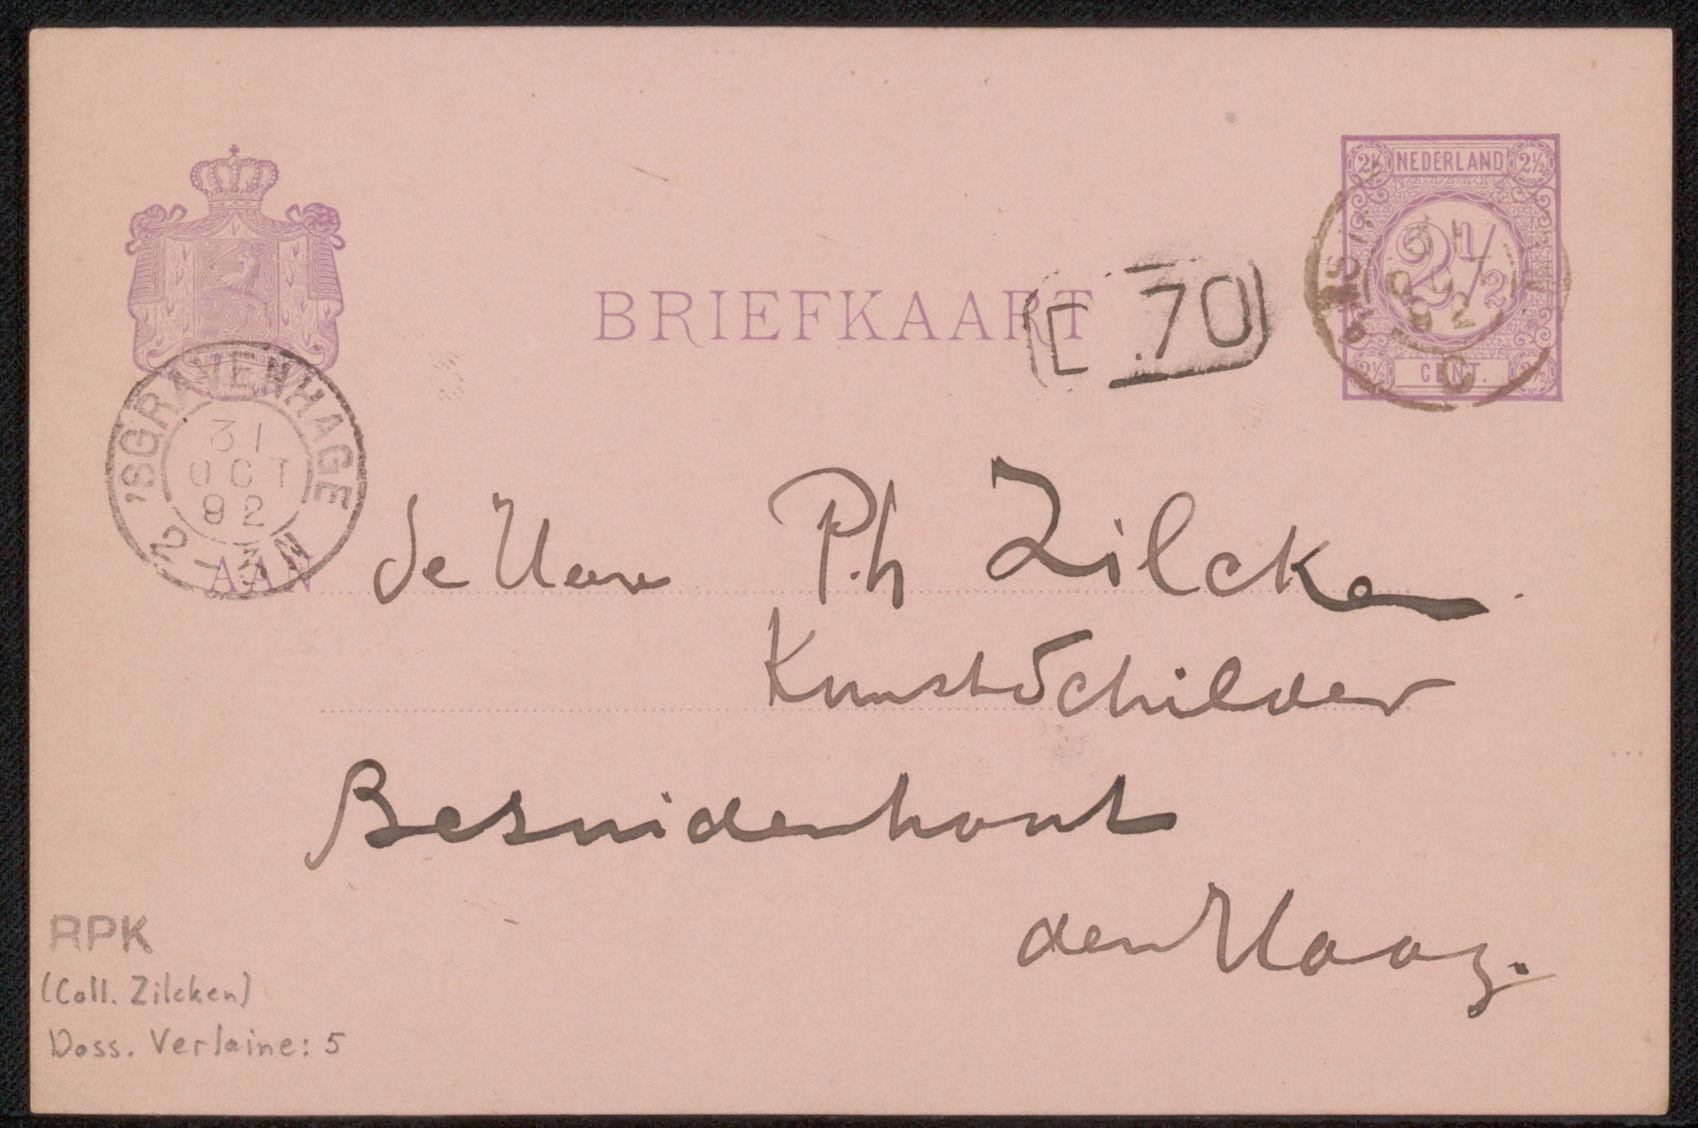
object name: postcard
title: Briefkaart aan Philip Zilcken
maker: wijnand bastiaan van horssen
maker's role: draughtsman, painter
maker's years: 1863-1931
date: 1892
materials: cardboard, ink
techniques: pen, writing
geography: rijswijk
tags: paris, paul verlaine, amsterdam, albert verwey, the hague, painter, draughtsman, philip zilcken, money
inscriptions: collector's mark: ‘RPK’